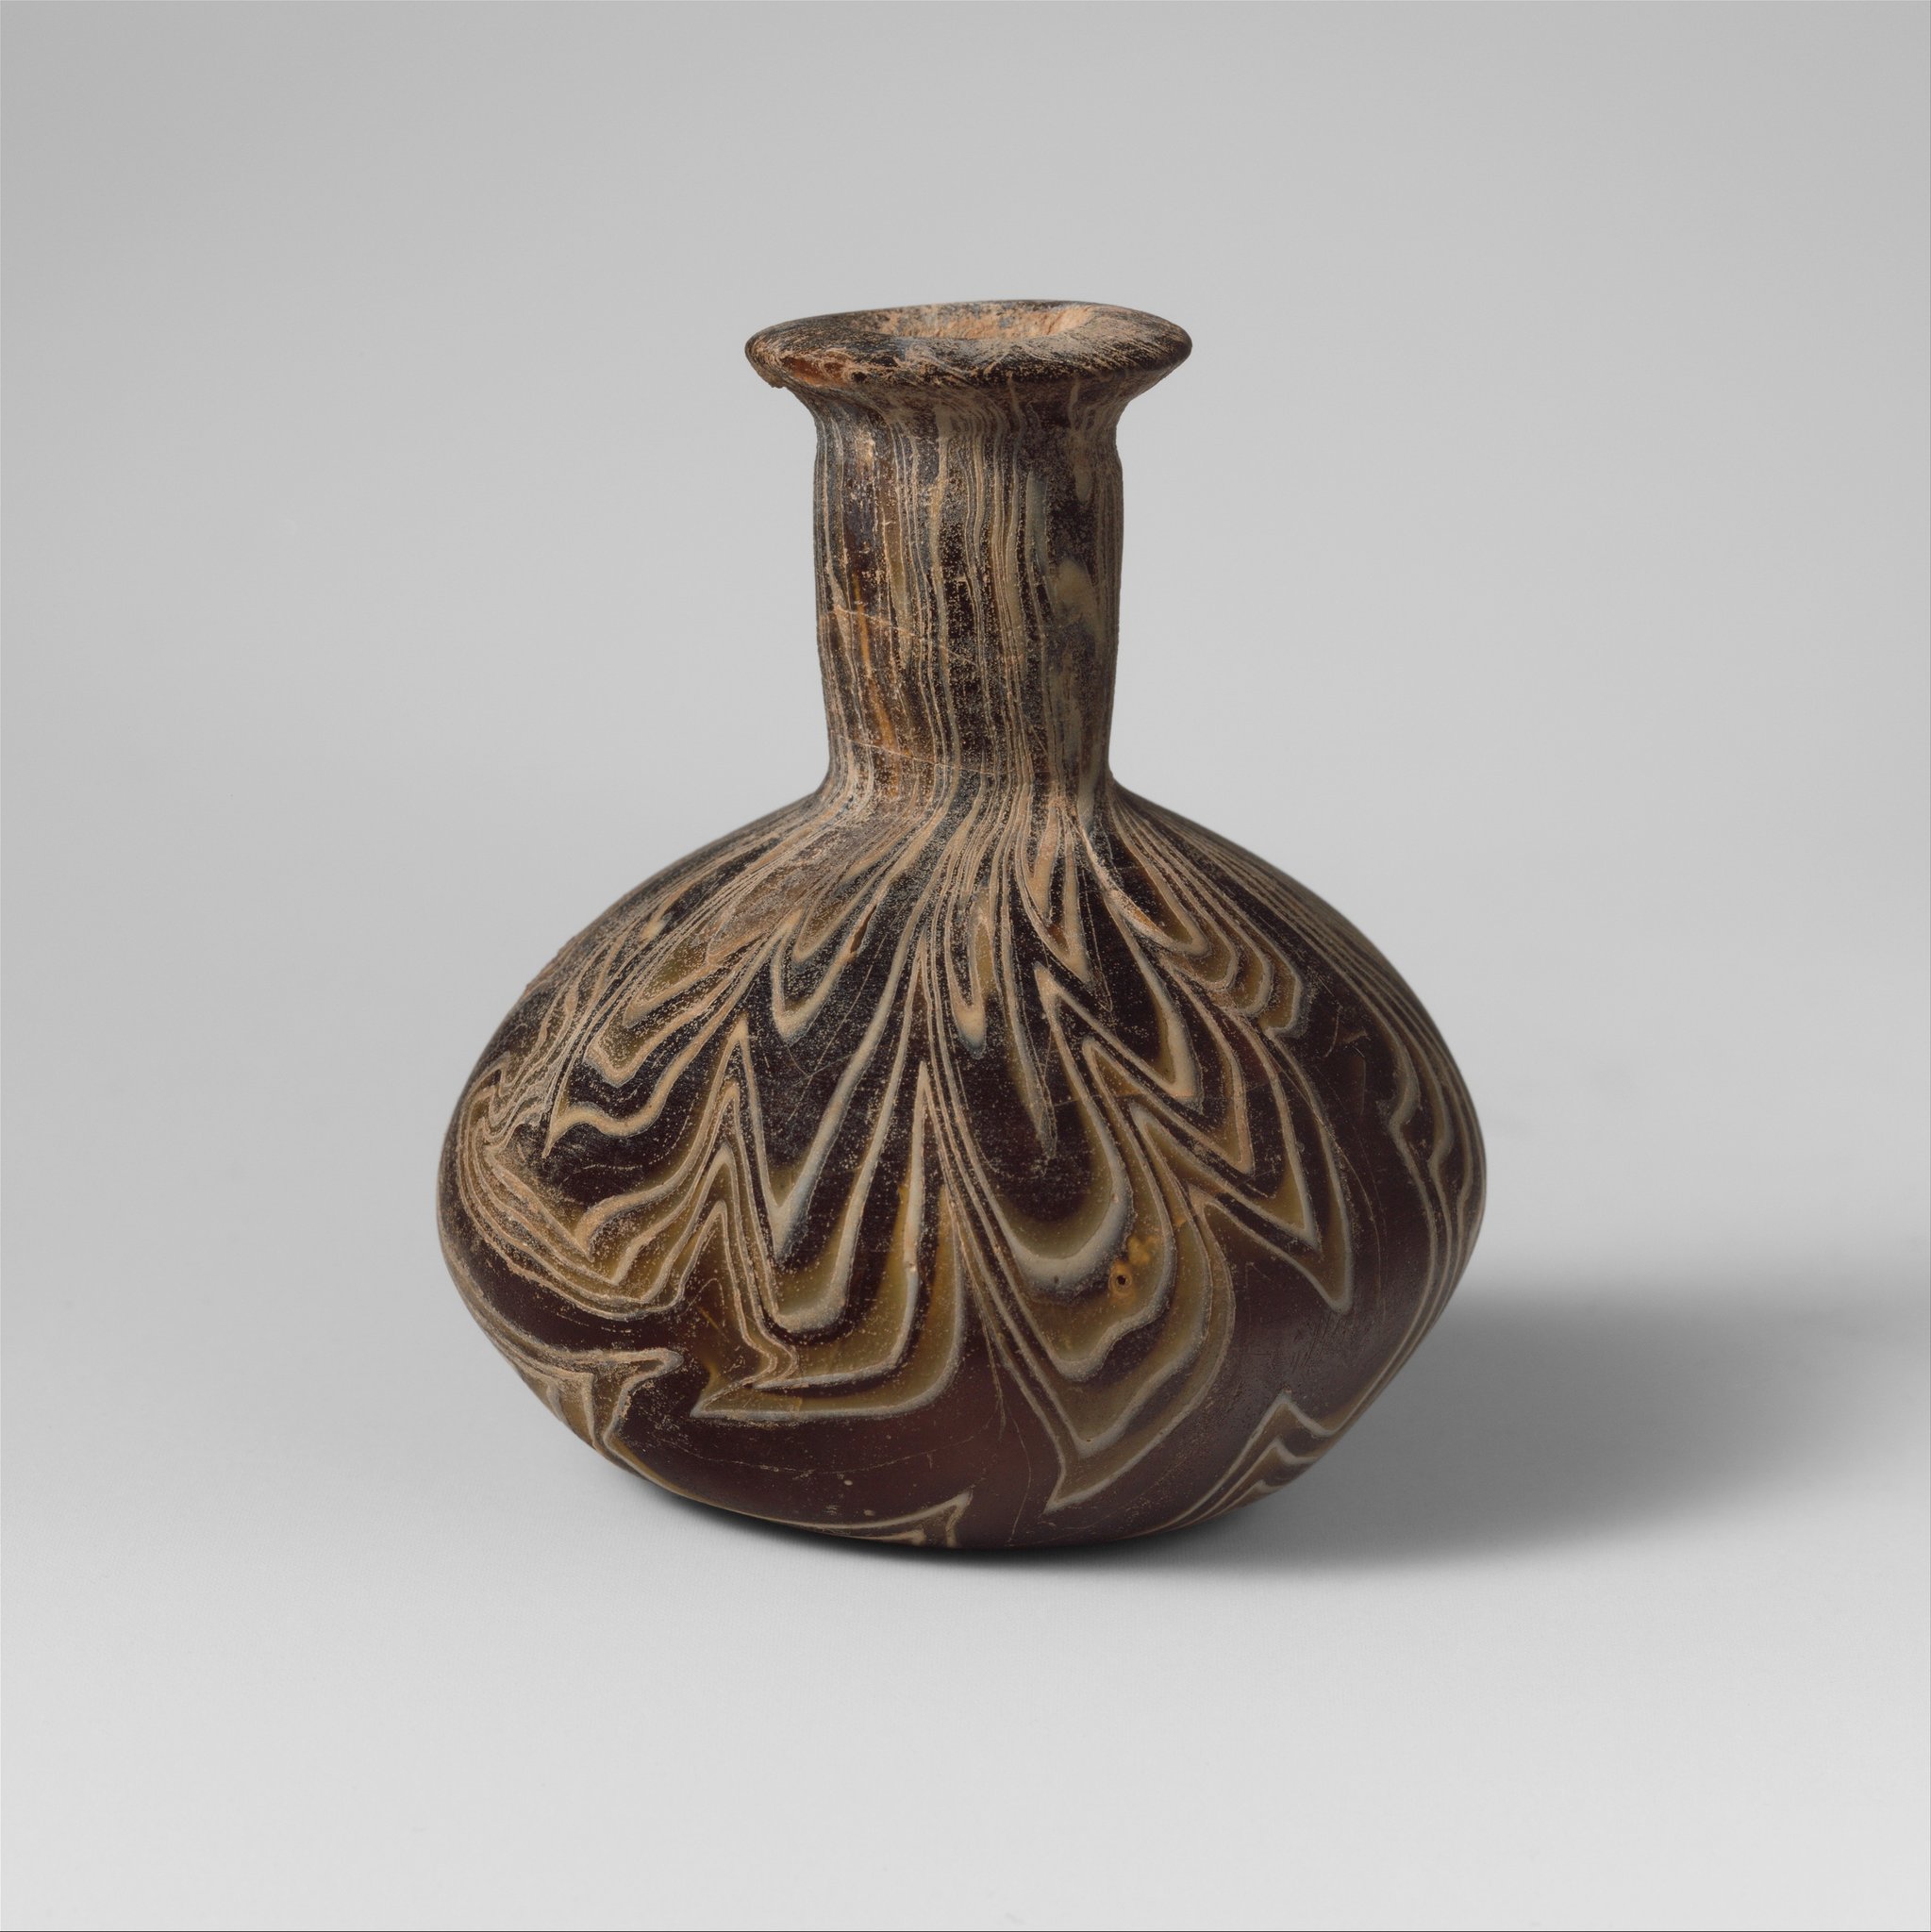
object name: perfume bottle, mosaic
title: Glass mosaic bottle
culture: roman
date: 1-50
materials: glass